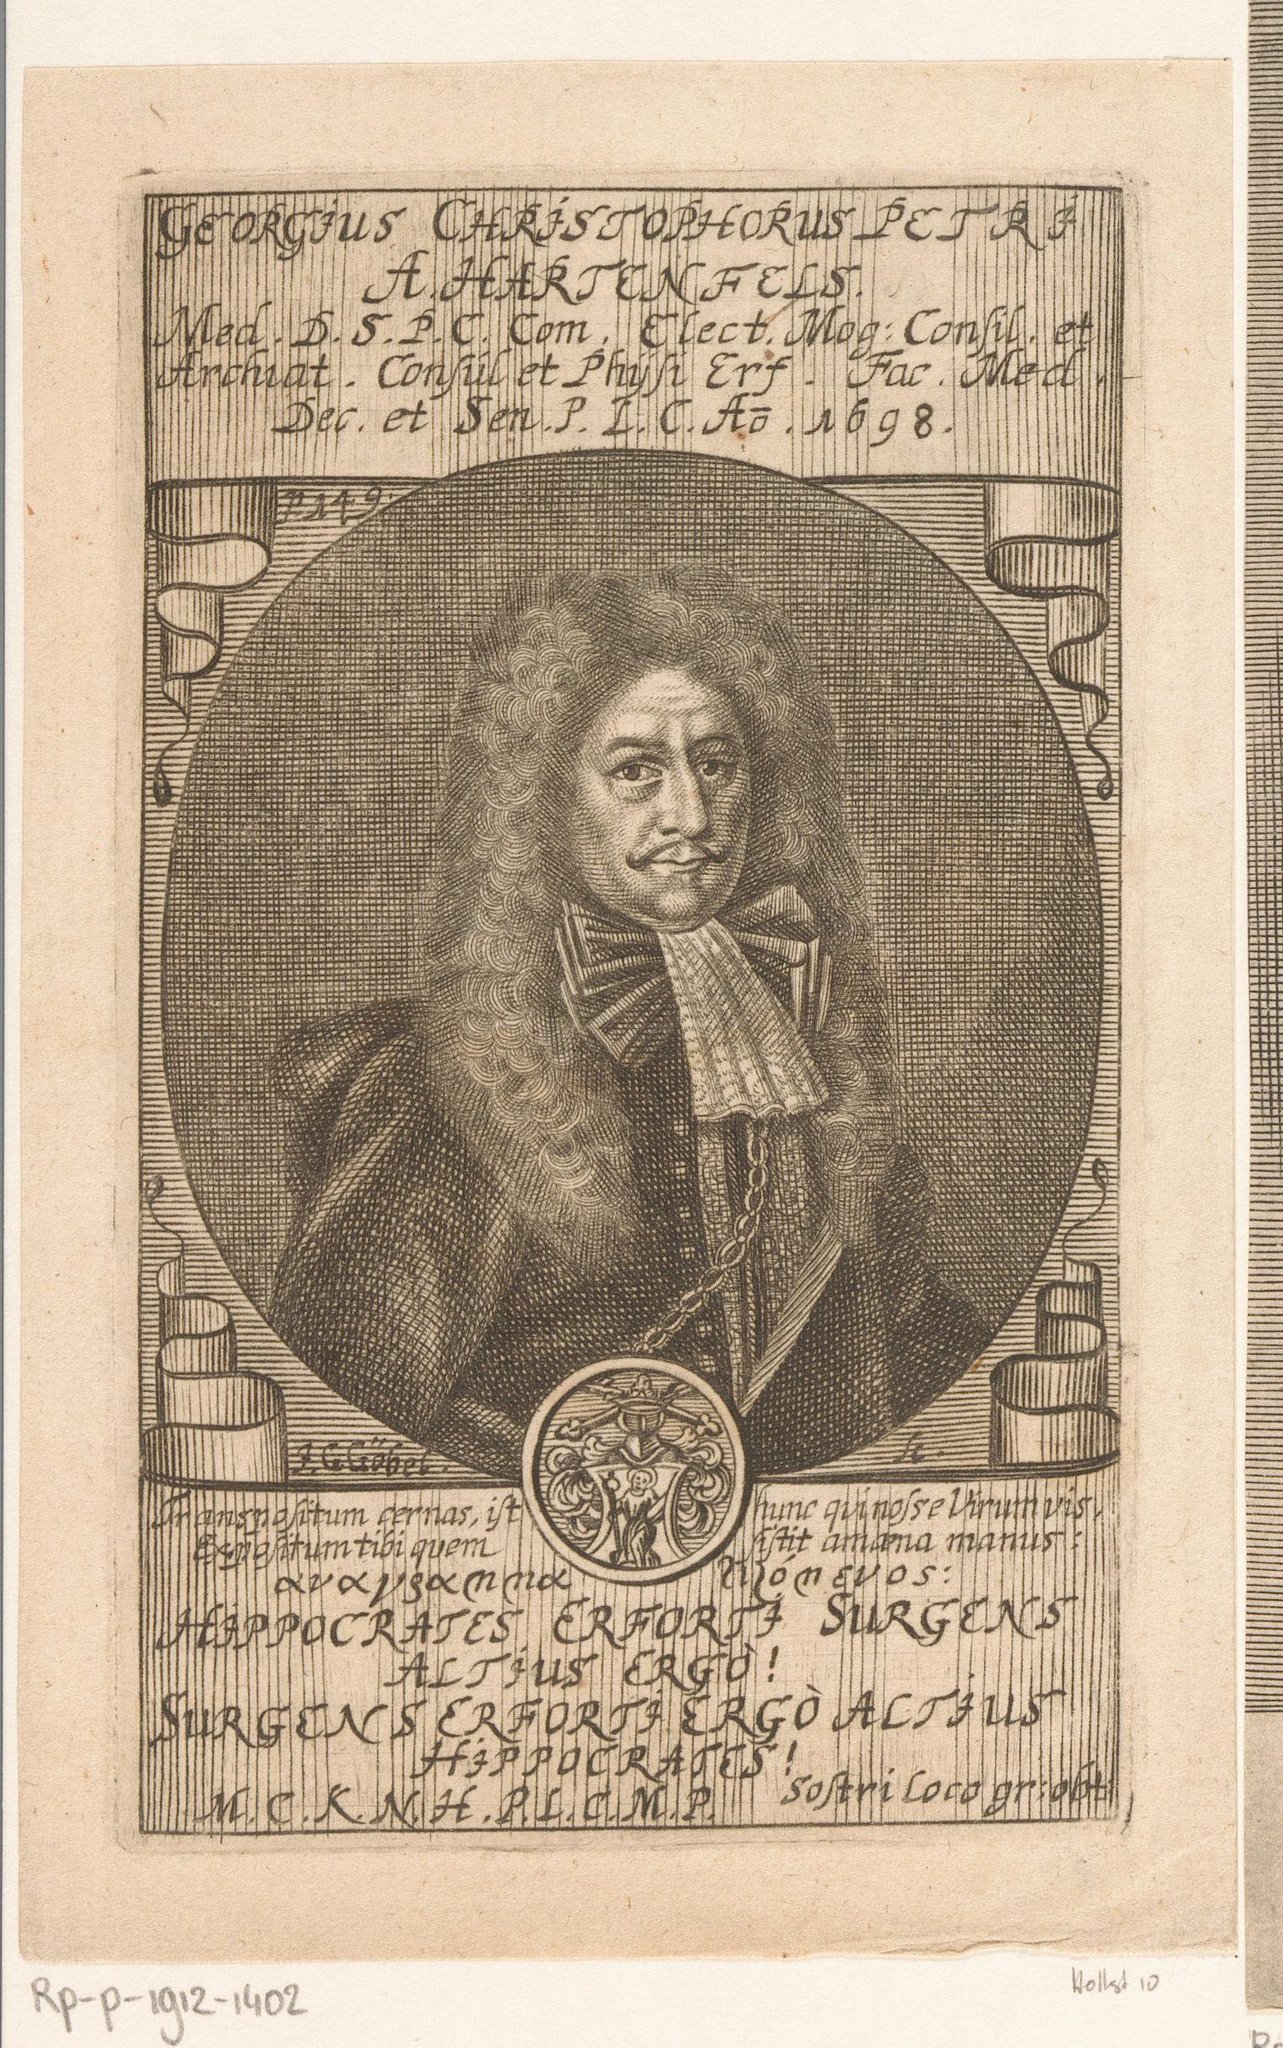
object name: print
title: Portret van Georg Christoph Petri von Hartenfels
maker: johann georg göbel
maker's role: print maker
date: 1698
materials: paper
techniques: engraving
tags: mayor, historical persons, ribbon, scroll, banderole ~ ornament, armorial bearing, heraldry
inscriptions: collector's mark: Lugt 2228